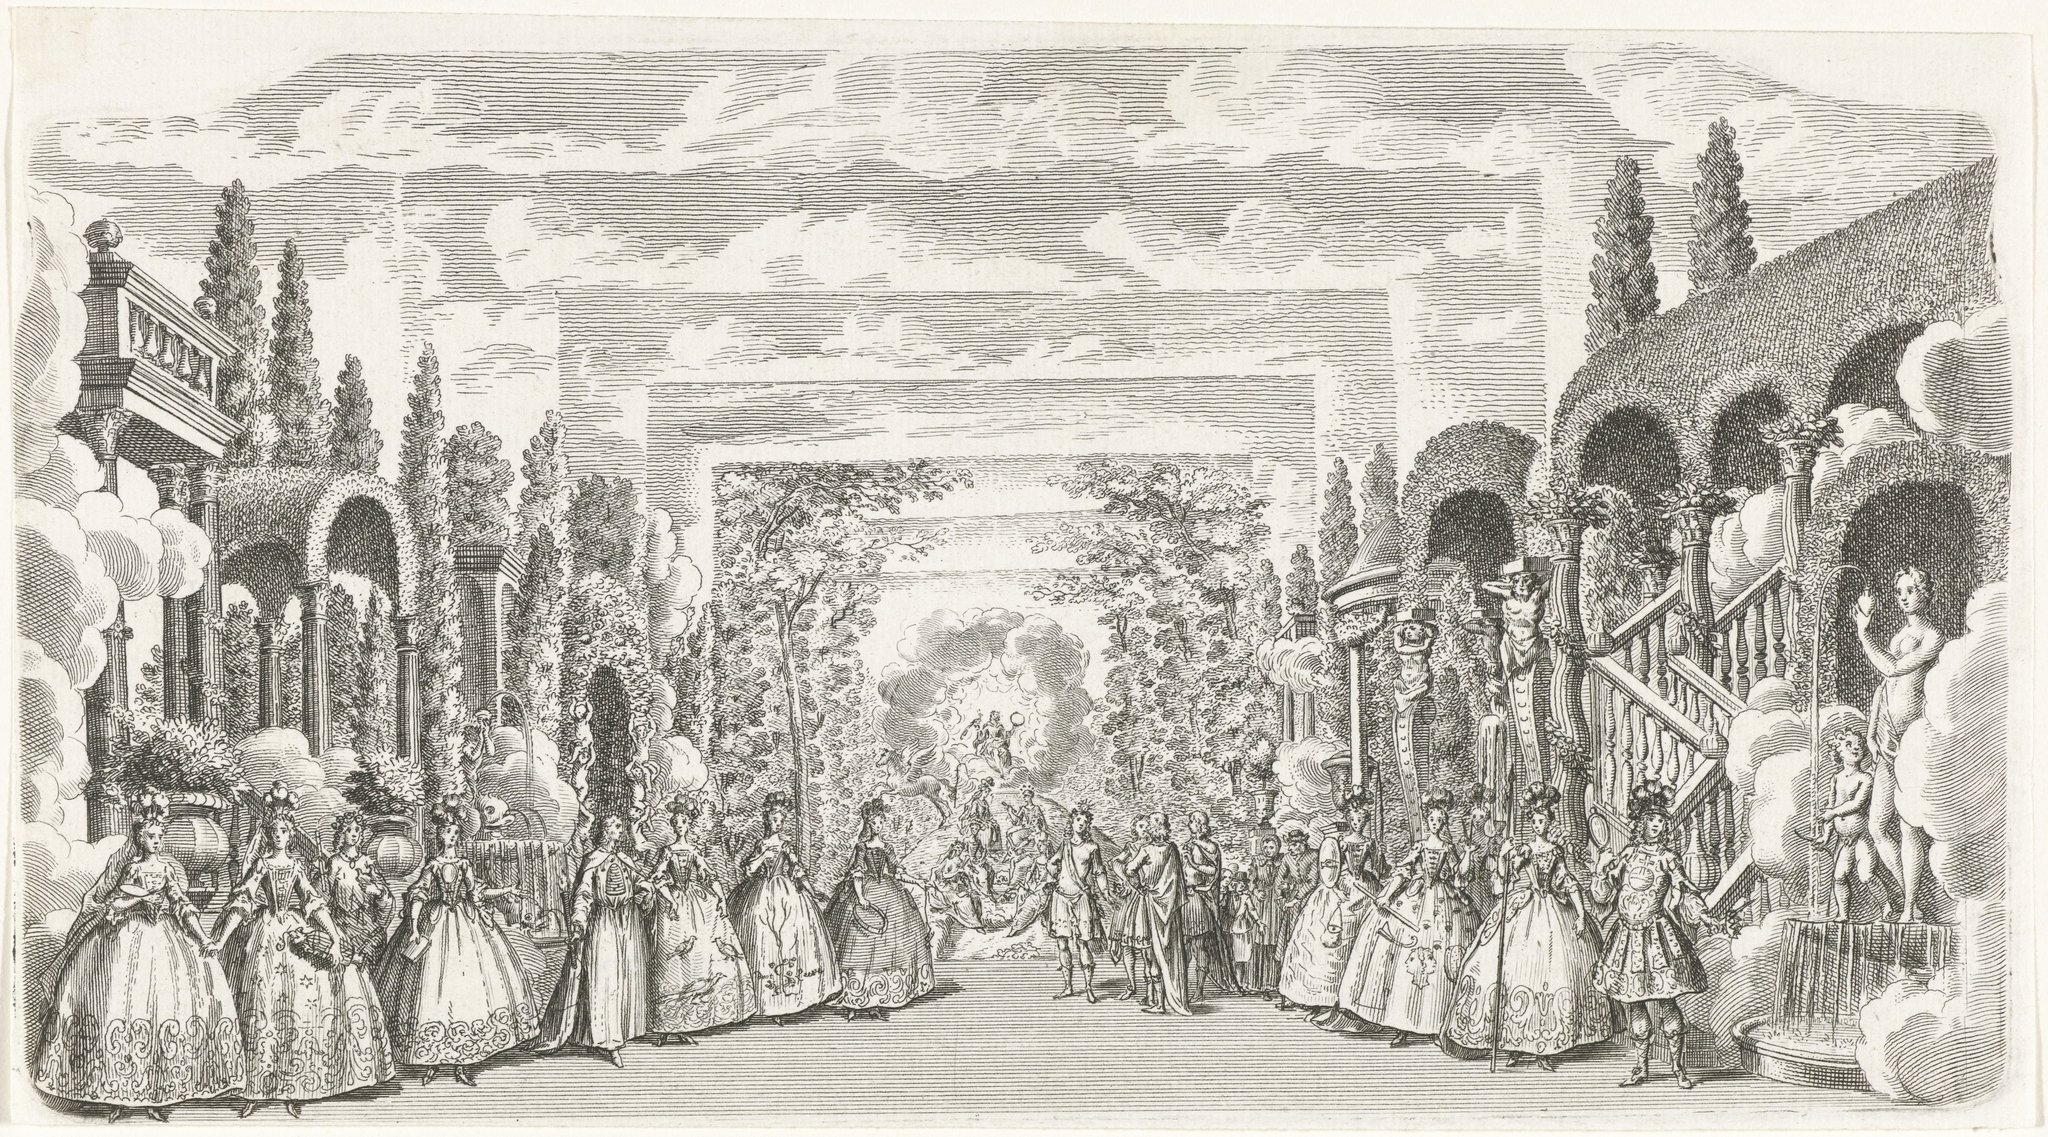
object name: print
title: Toneeldecor: De Berg van Parnas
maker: jan punt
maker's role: draughtsman, print maker, publisher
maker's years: 1711-1779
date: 1738-1740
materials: paper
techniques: engraving, etching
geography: amsterdam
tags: theatre, theatrical performance, stage design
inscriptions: collector's mark: Lugt 2228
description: Scène uit het toneelstuk "Het Eeuwgetijde van den Amsteldamschen Schouwburg" door Jan de Marre, Amsterdam 1738. Deze platen zijn in verschillende groepen in verschillende periodes vervaardigd tussen 1738-1760 en uitgegeven in verschillende series ca. 1760 en ca. 1770-1772. De platen zijn door Muller ingedeeld bij de platen van de brand van de Amsterdamse Schouwburg in 1772.